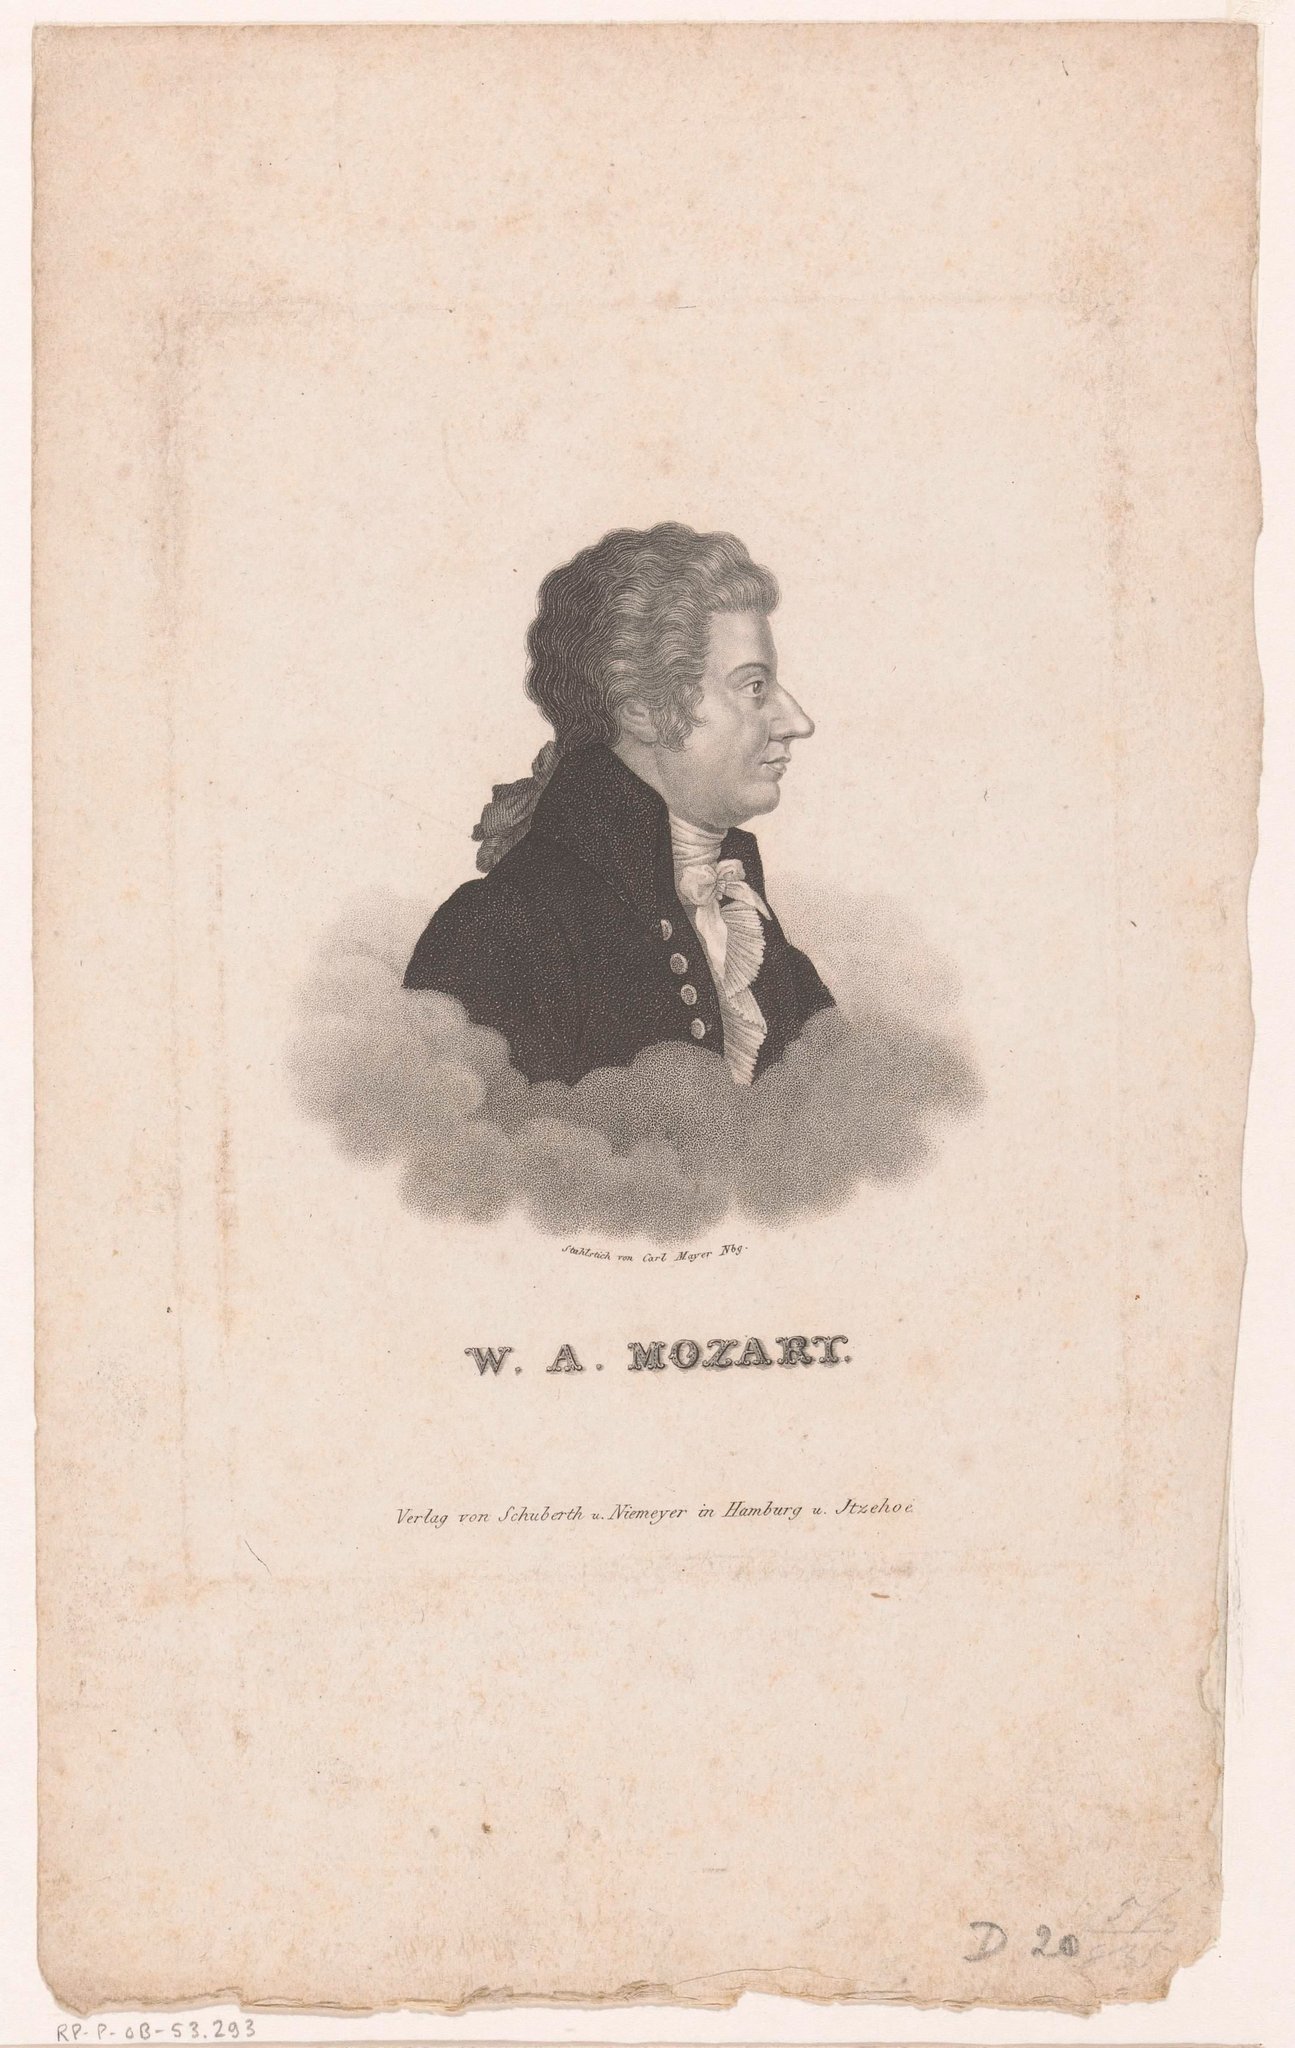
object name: print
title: Portret van Wolfgang Amadeus Mozart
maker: carl mayer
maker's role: print maker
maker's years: 1798-1868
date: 1829-1839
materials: paper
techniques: engraving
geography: nuremberg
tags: vienna, historical persons